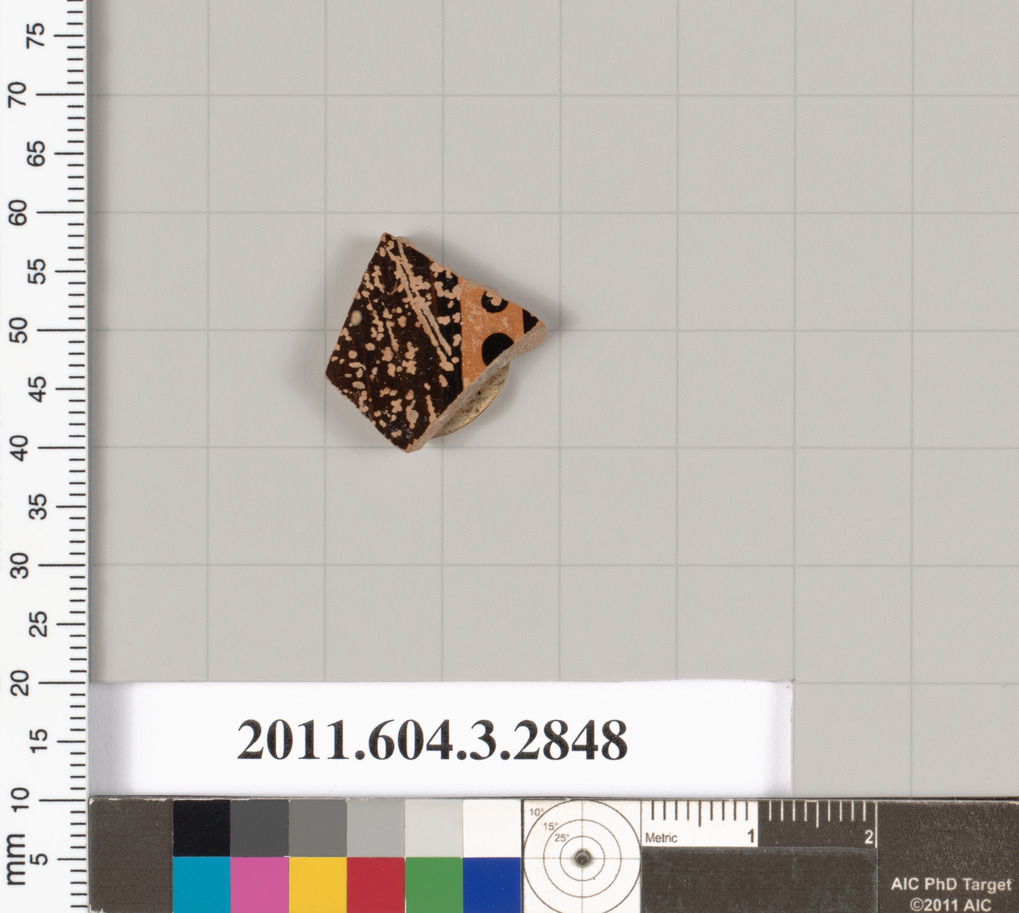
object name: undetermined closed shape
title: Terracotta fragment of a closed shape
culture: greek, attic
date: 534-468 BCE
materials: terracotta